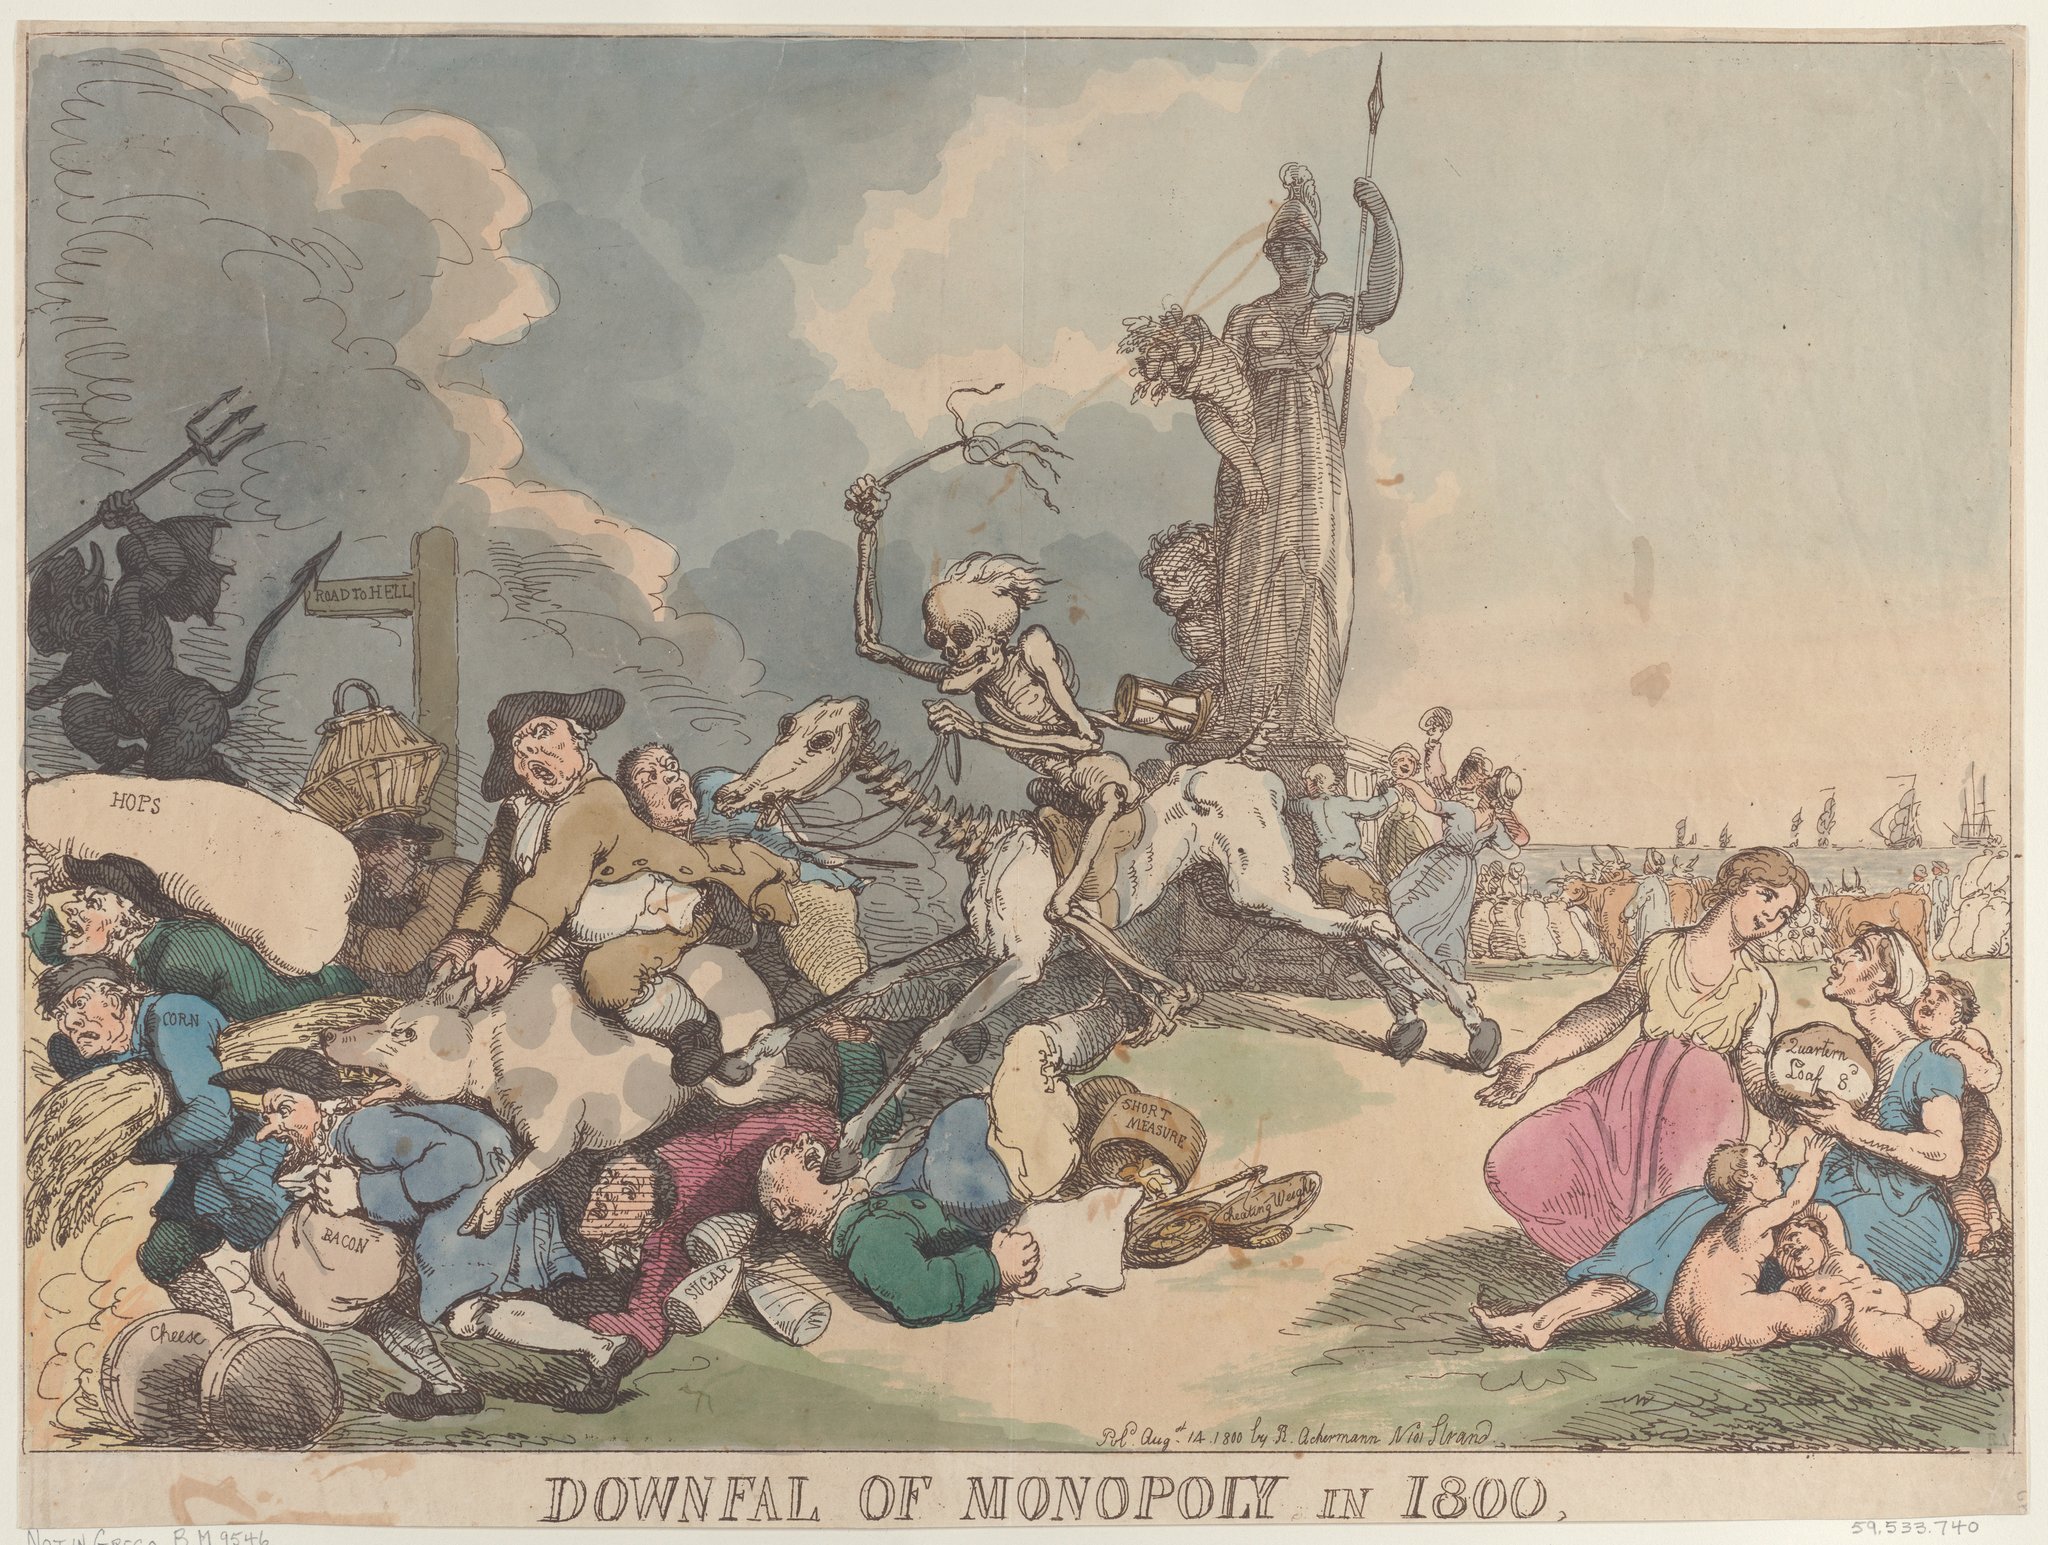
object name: print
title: Downfall of Monopoly in 1800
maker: thomas rowlandson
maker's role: artist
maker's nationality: british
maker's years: 1757-1827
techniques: etching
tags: satire,skeletons,men,women